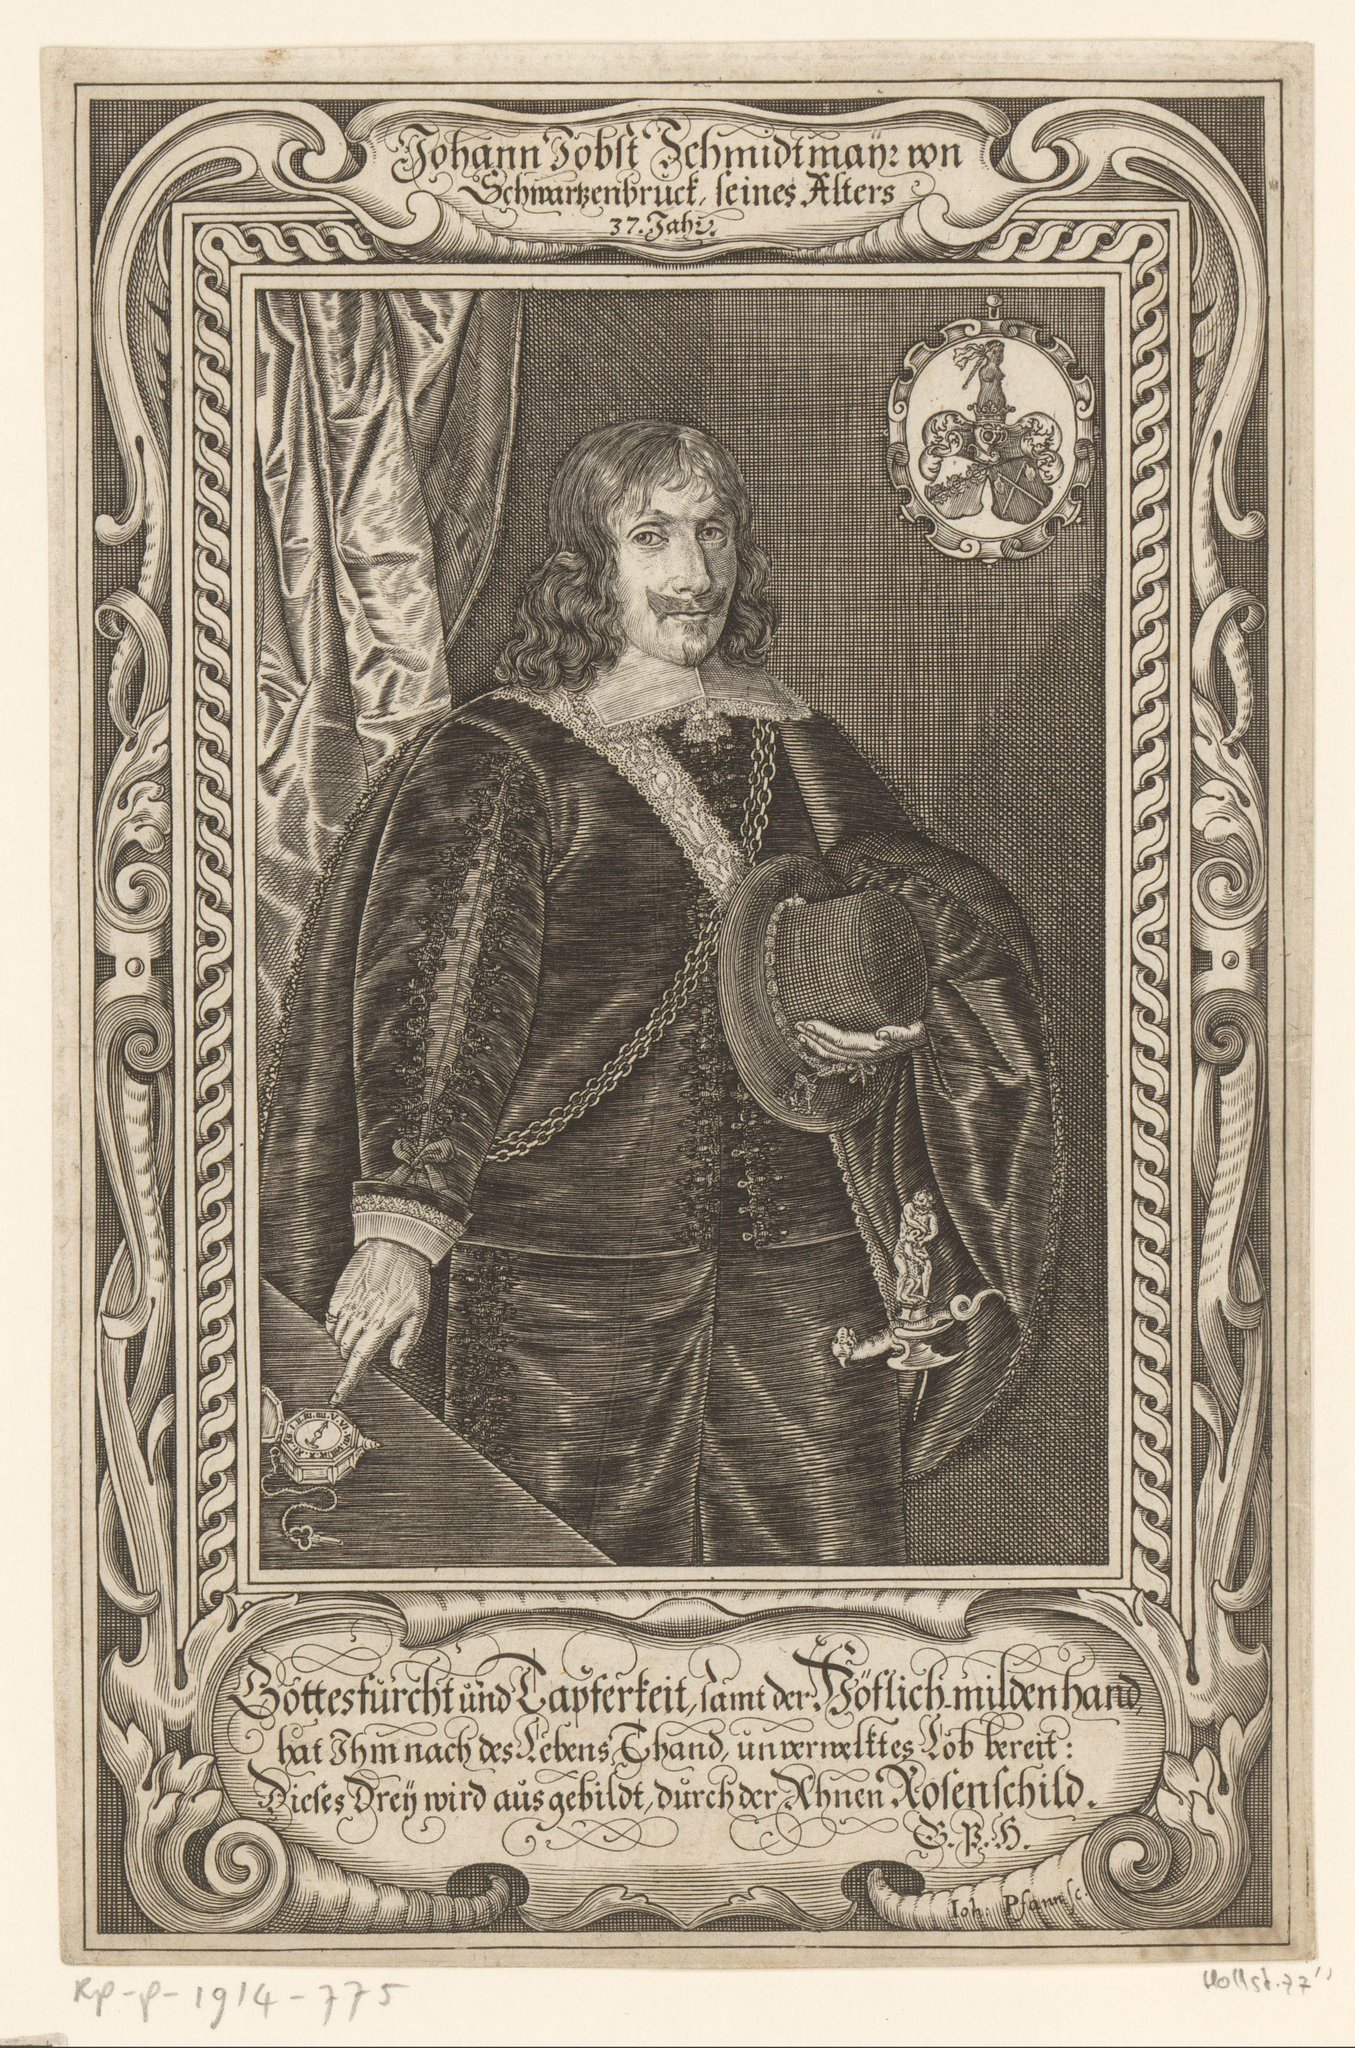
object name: print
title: Portret van Johann Jodocus Schmidmair von Schwarzenbruck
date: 1648-1663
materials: paper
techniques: engraving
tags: historical persons, hacking and thrusting weapons: sword, watch, armorial bearing, heraldry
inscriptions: collector's mark: Lugt 2228